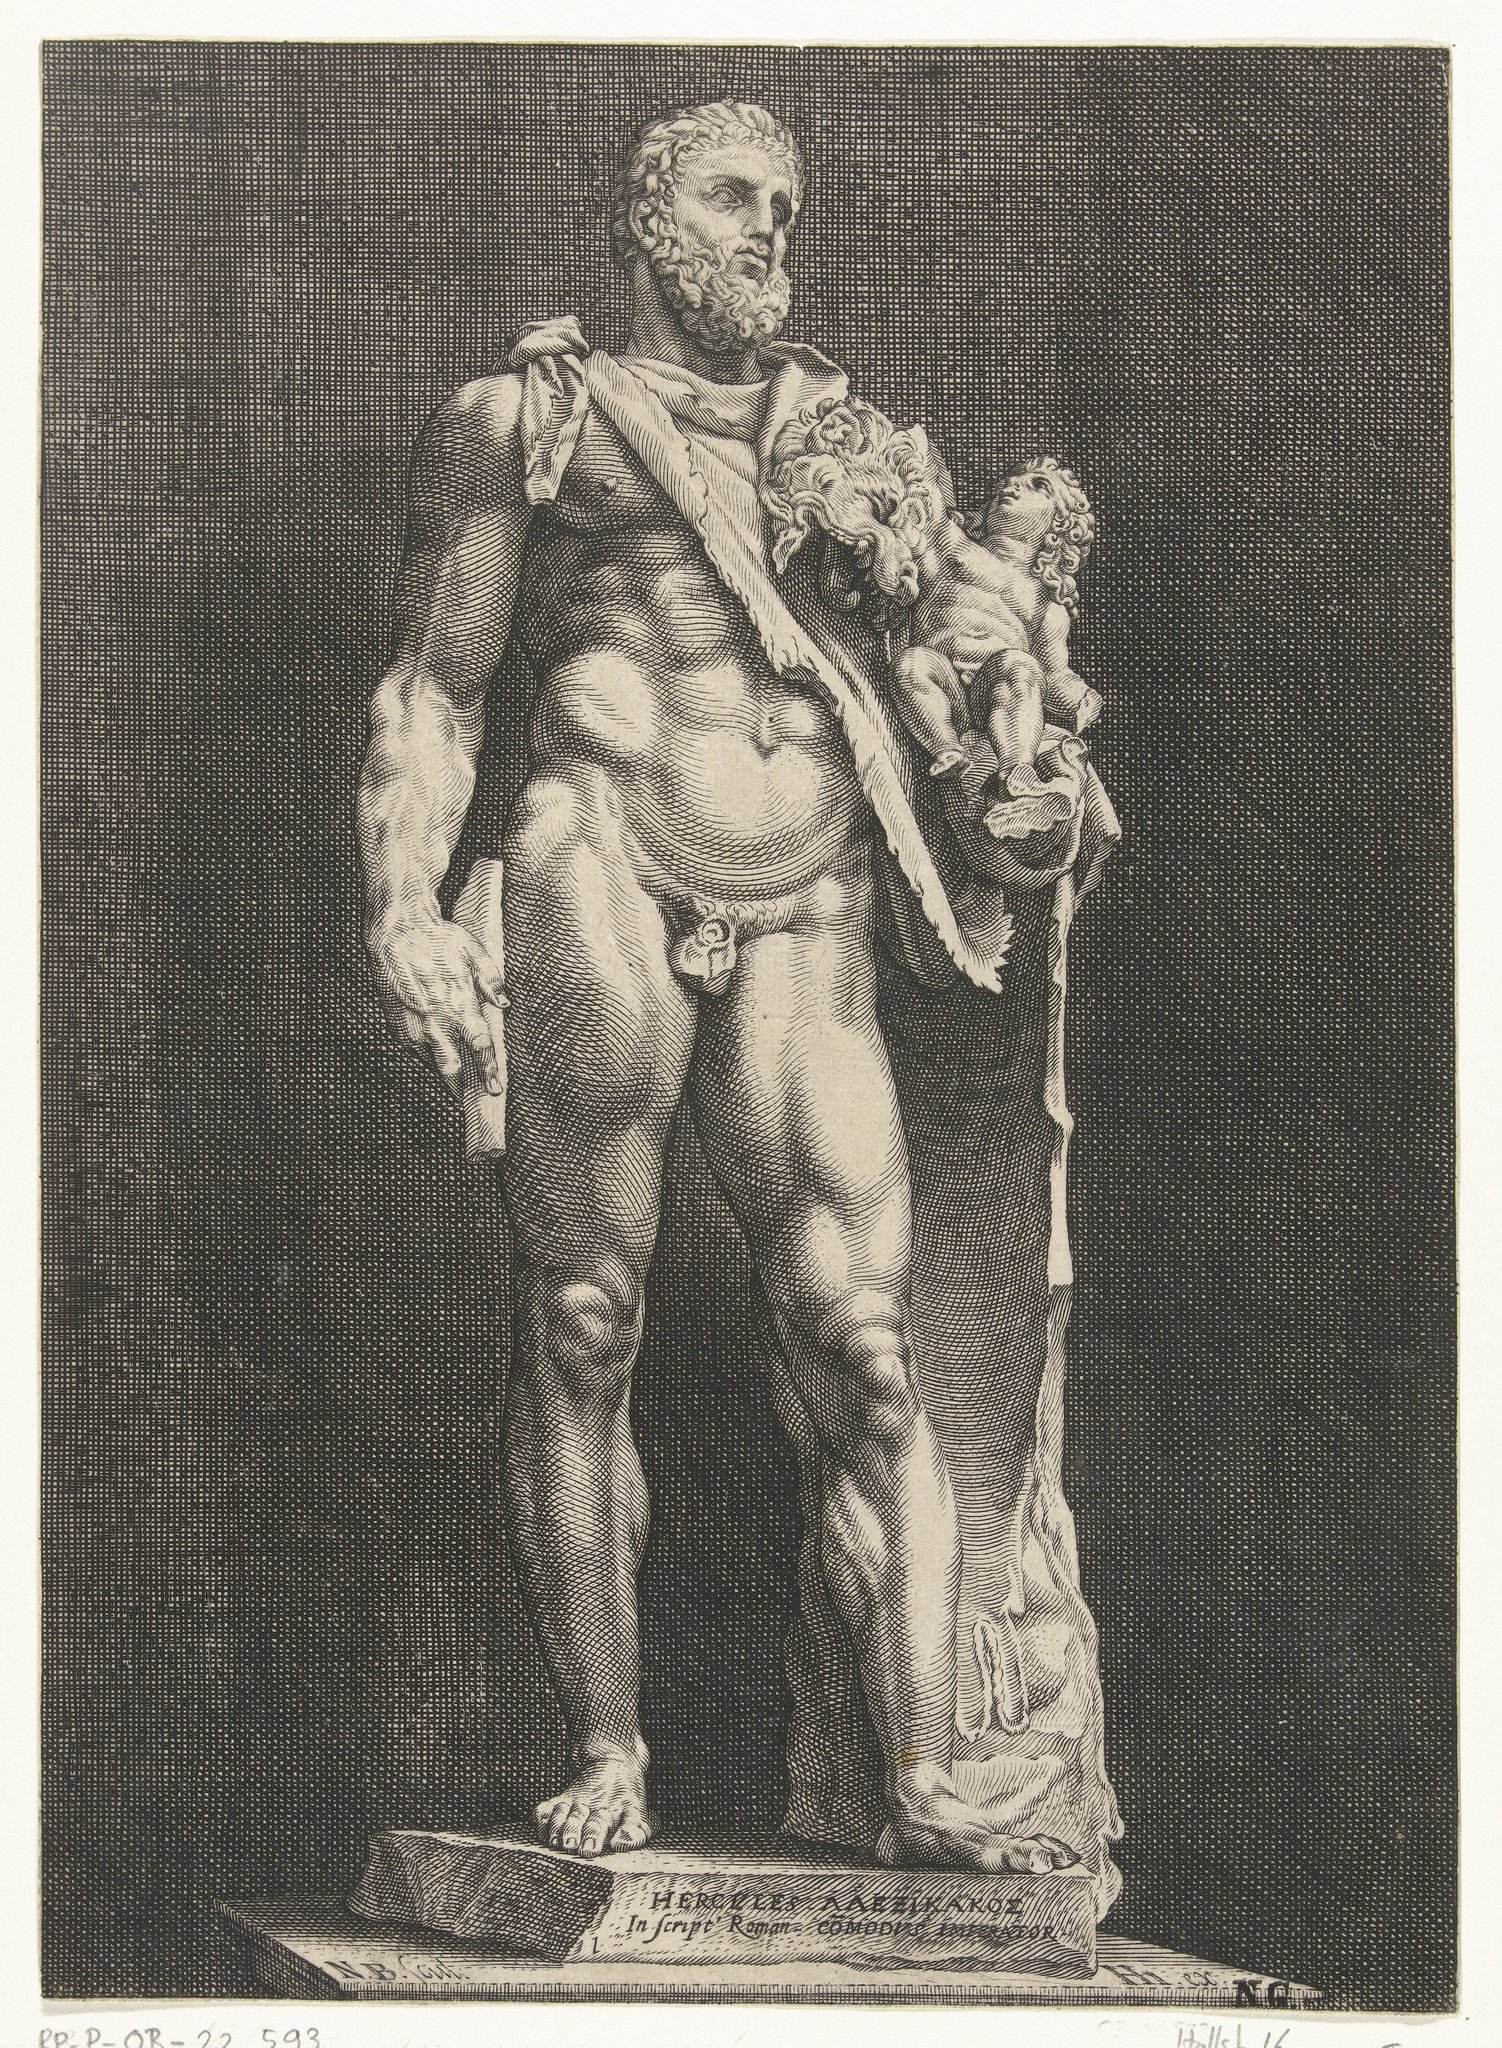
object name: print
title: Drie antieke beelden te Rome naar Goltzius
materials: paper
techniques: engraving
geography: netherlands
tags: (story of) hercules (heracles), piece of sculpture, reproduction of a piece of sculpture, (story of) telephus, (story of) commodus the roman emperor (+ mythological or allegorical portrait; allegorical representation of event from the life of historical person)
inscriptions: collector's mark: Lugt 2228, collector's mark: Lugt 1967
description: Een beeld van Hercules met zijn zoon Telephos op zijn arm. Over Hercules schouder hangt zijn leeuwenhuid en het kind speelt met de kop van de leeuw. Op de inscriptie op de sokkel van het beeld wordt Hercules geassocieerd met de Romeinse keizer Commodus die probeerde Hercules moed en kracht te evenaren.